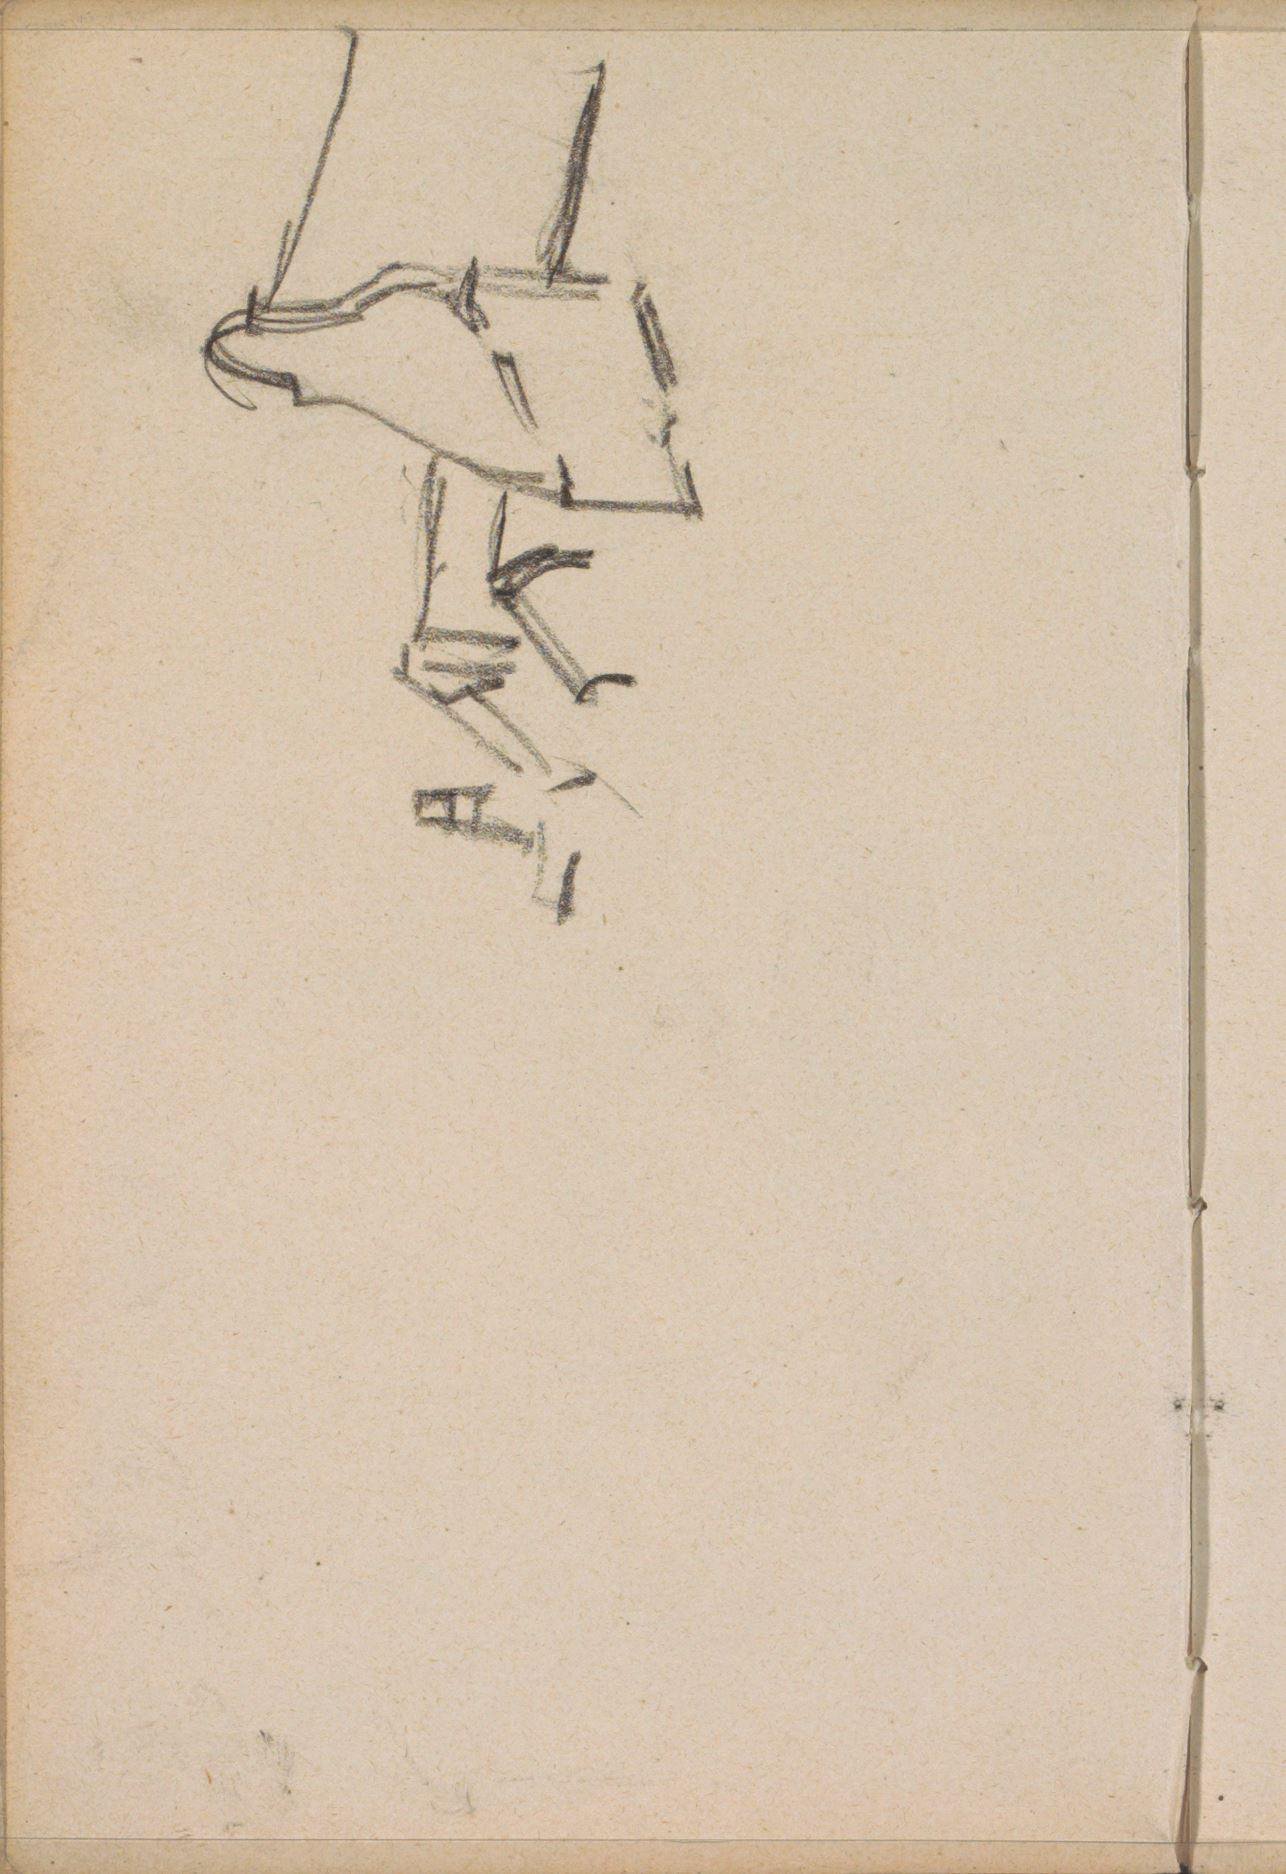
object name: sketchbook leaf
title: Gevels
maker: george hendrik breitner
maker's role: draughtsman, painter, print maker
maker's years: 1857-1923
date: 1900-1923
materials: chalk, paper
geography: amsterdam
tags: façade (of house or building), amsterdam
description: Pagina 13 uit een schetsboek met 39 bladen.